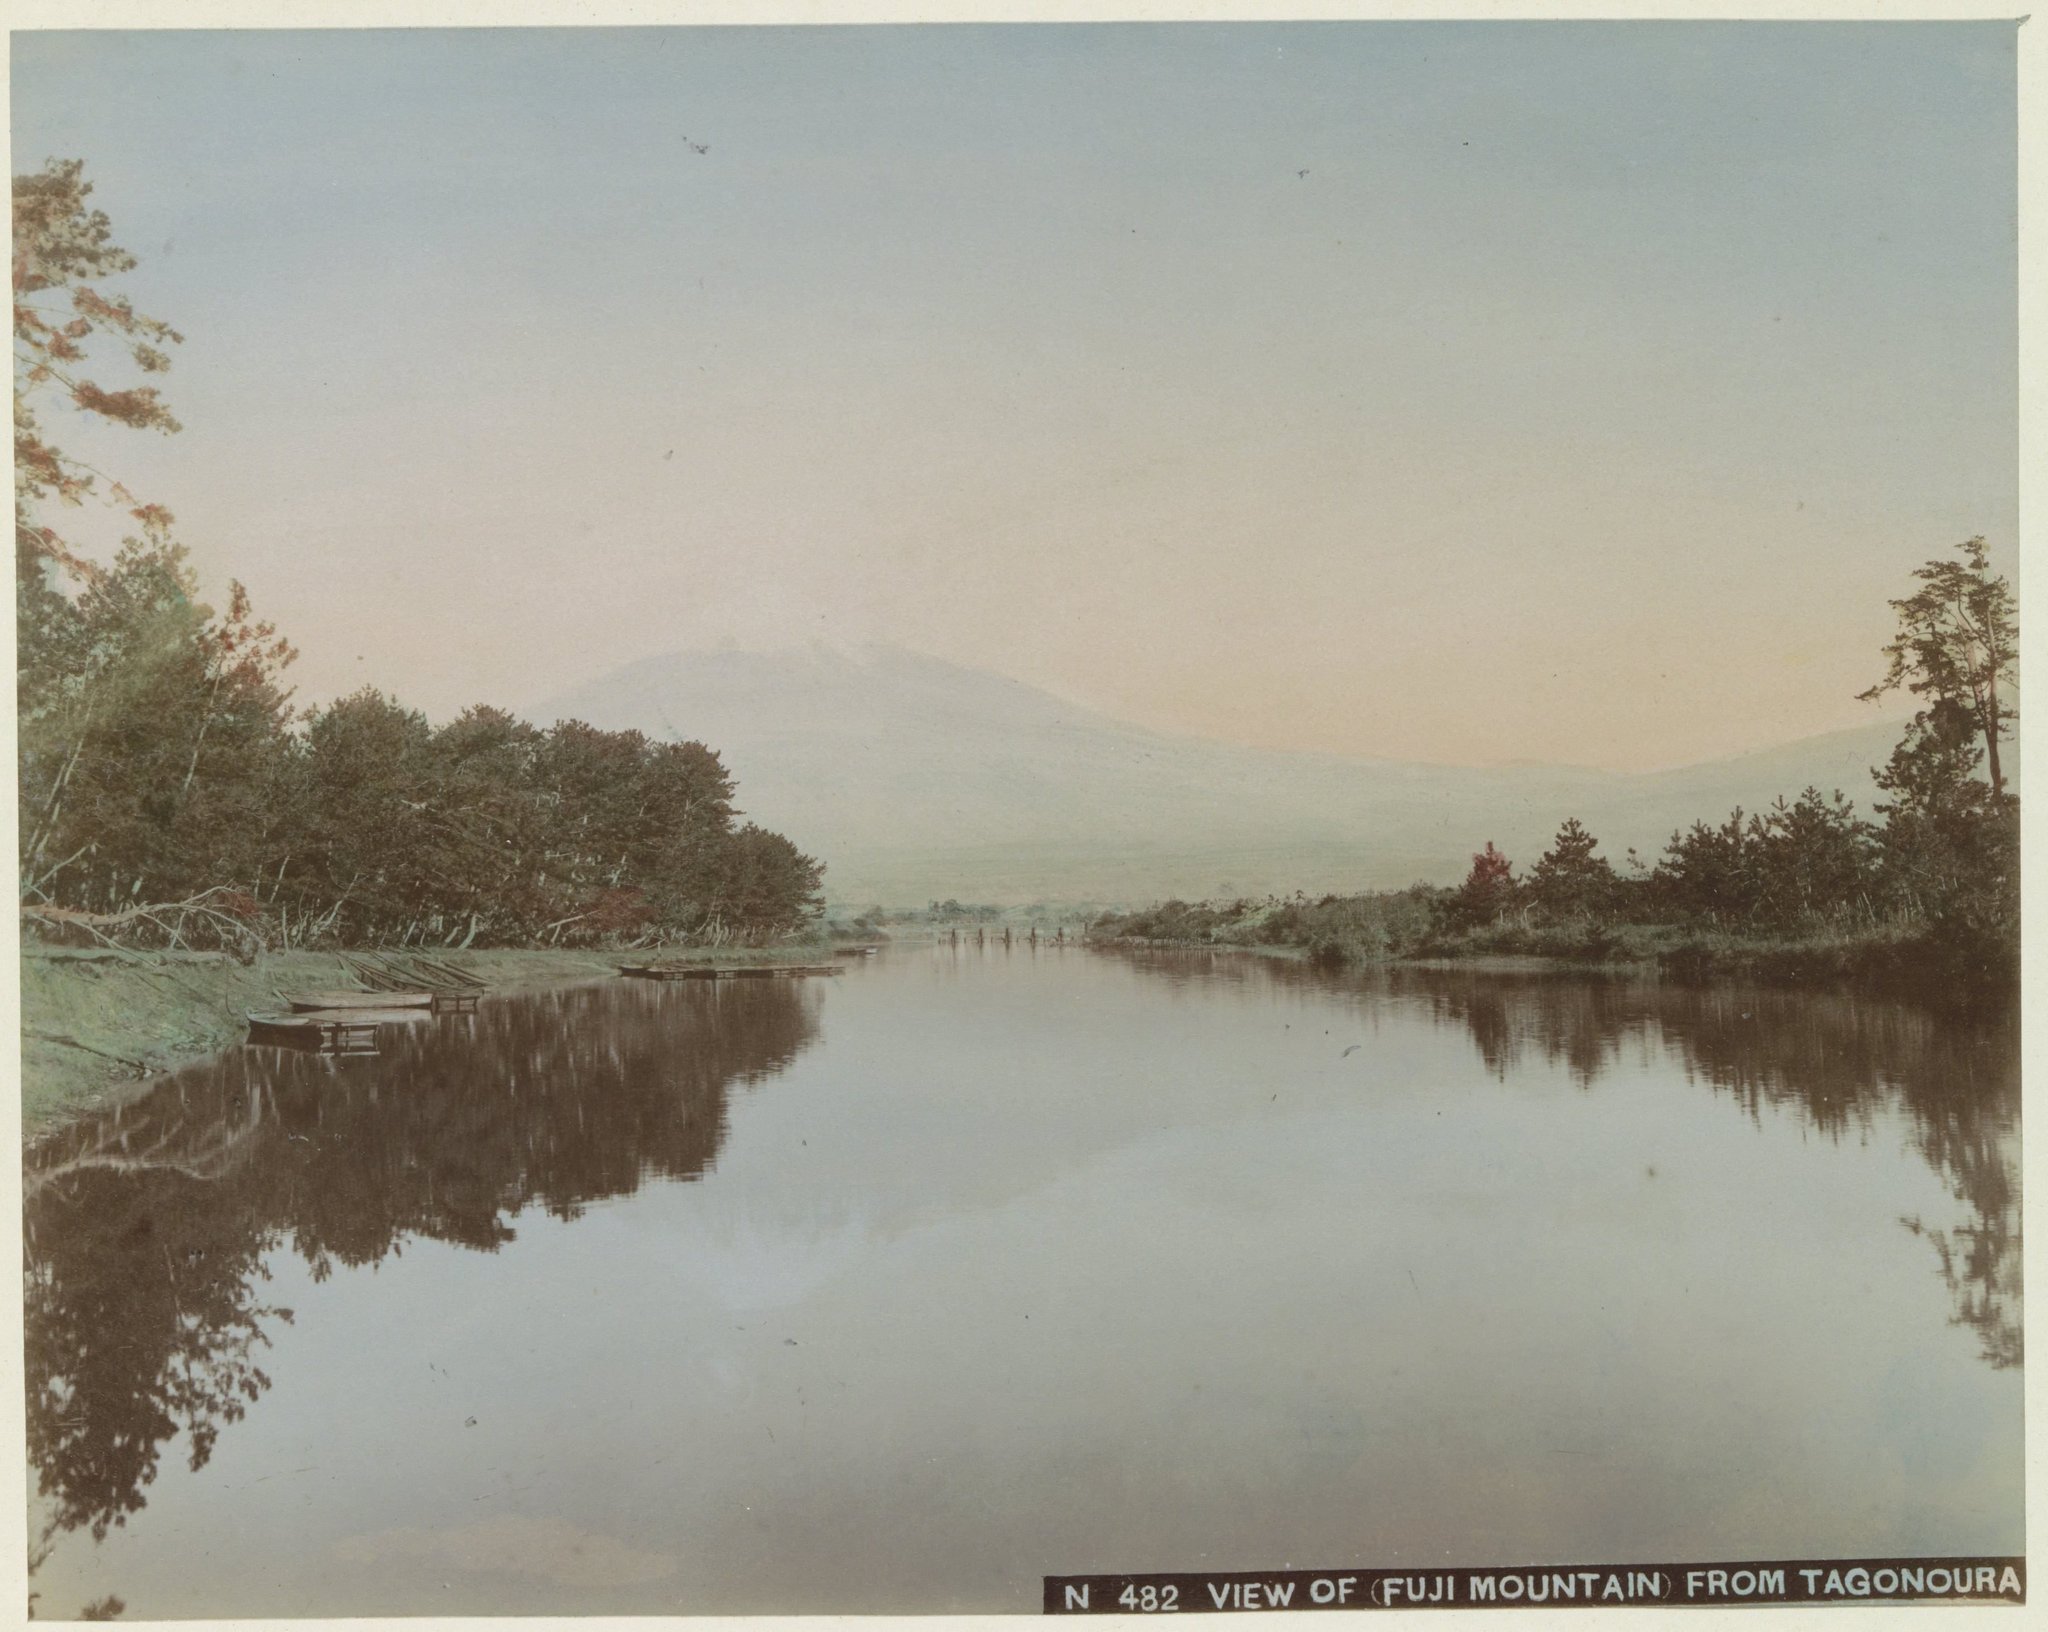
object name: photograph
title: View of Fuji Mountain from Tagonoura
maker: Anonymous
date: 1870-1900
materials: cardboard, paper, photographic support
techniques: albumen print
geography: japan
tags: mountain-top, peak (+ landscape with figures, staffage)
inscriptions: negative number: ‘N 482’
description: Onderdeel van Reisalbum met foto's van bezienswaardigheden in Japan.